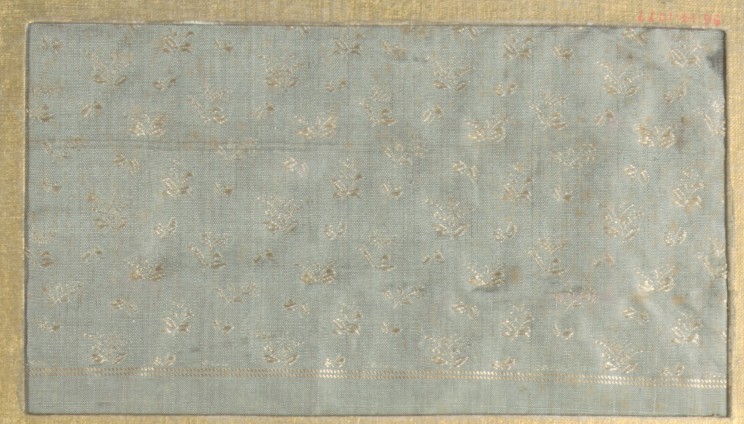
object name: piece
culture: japanese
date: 1701-1900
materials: silk